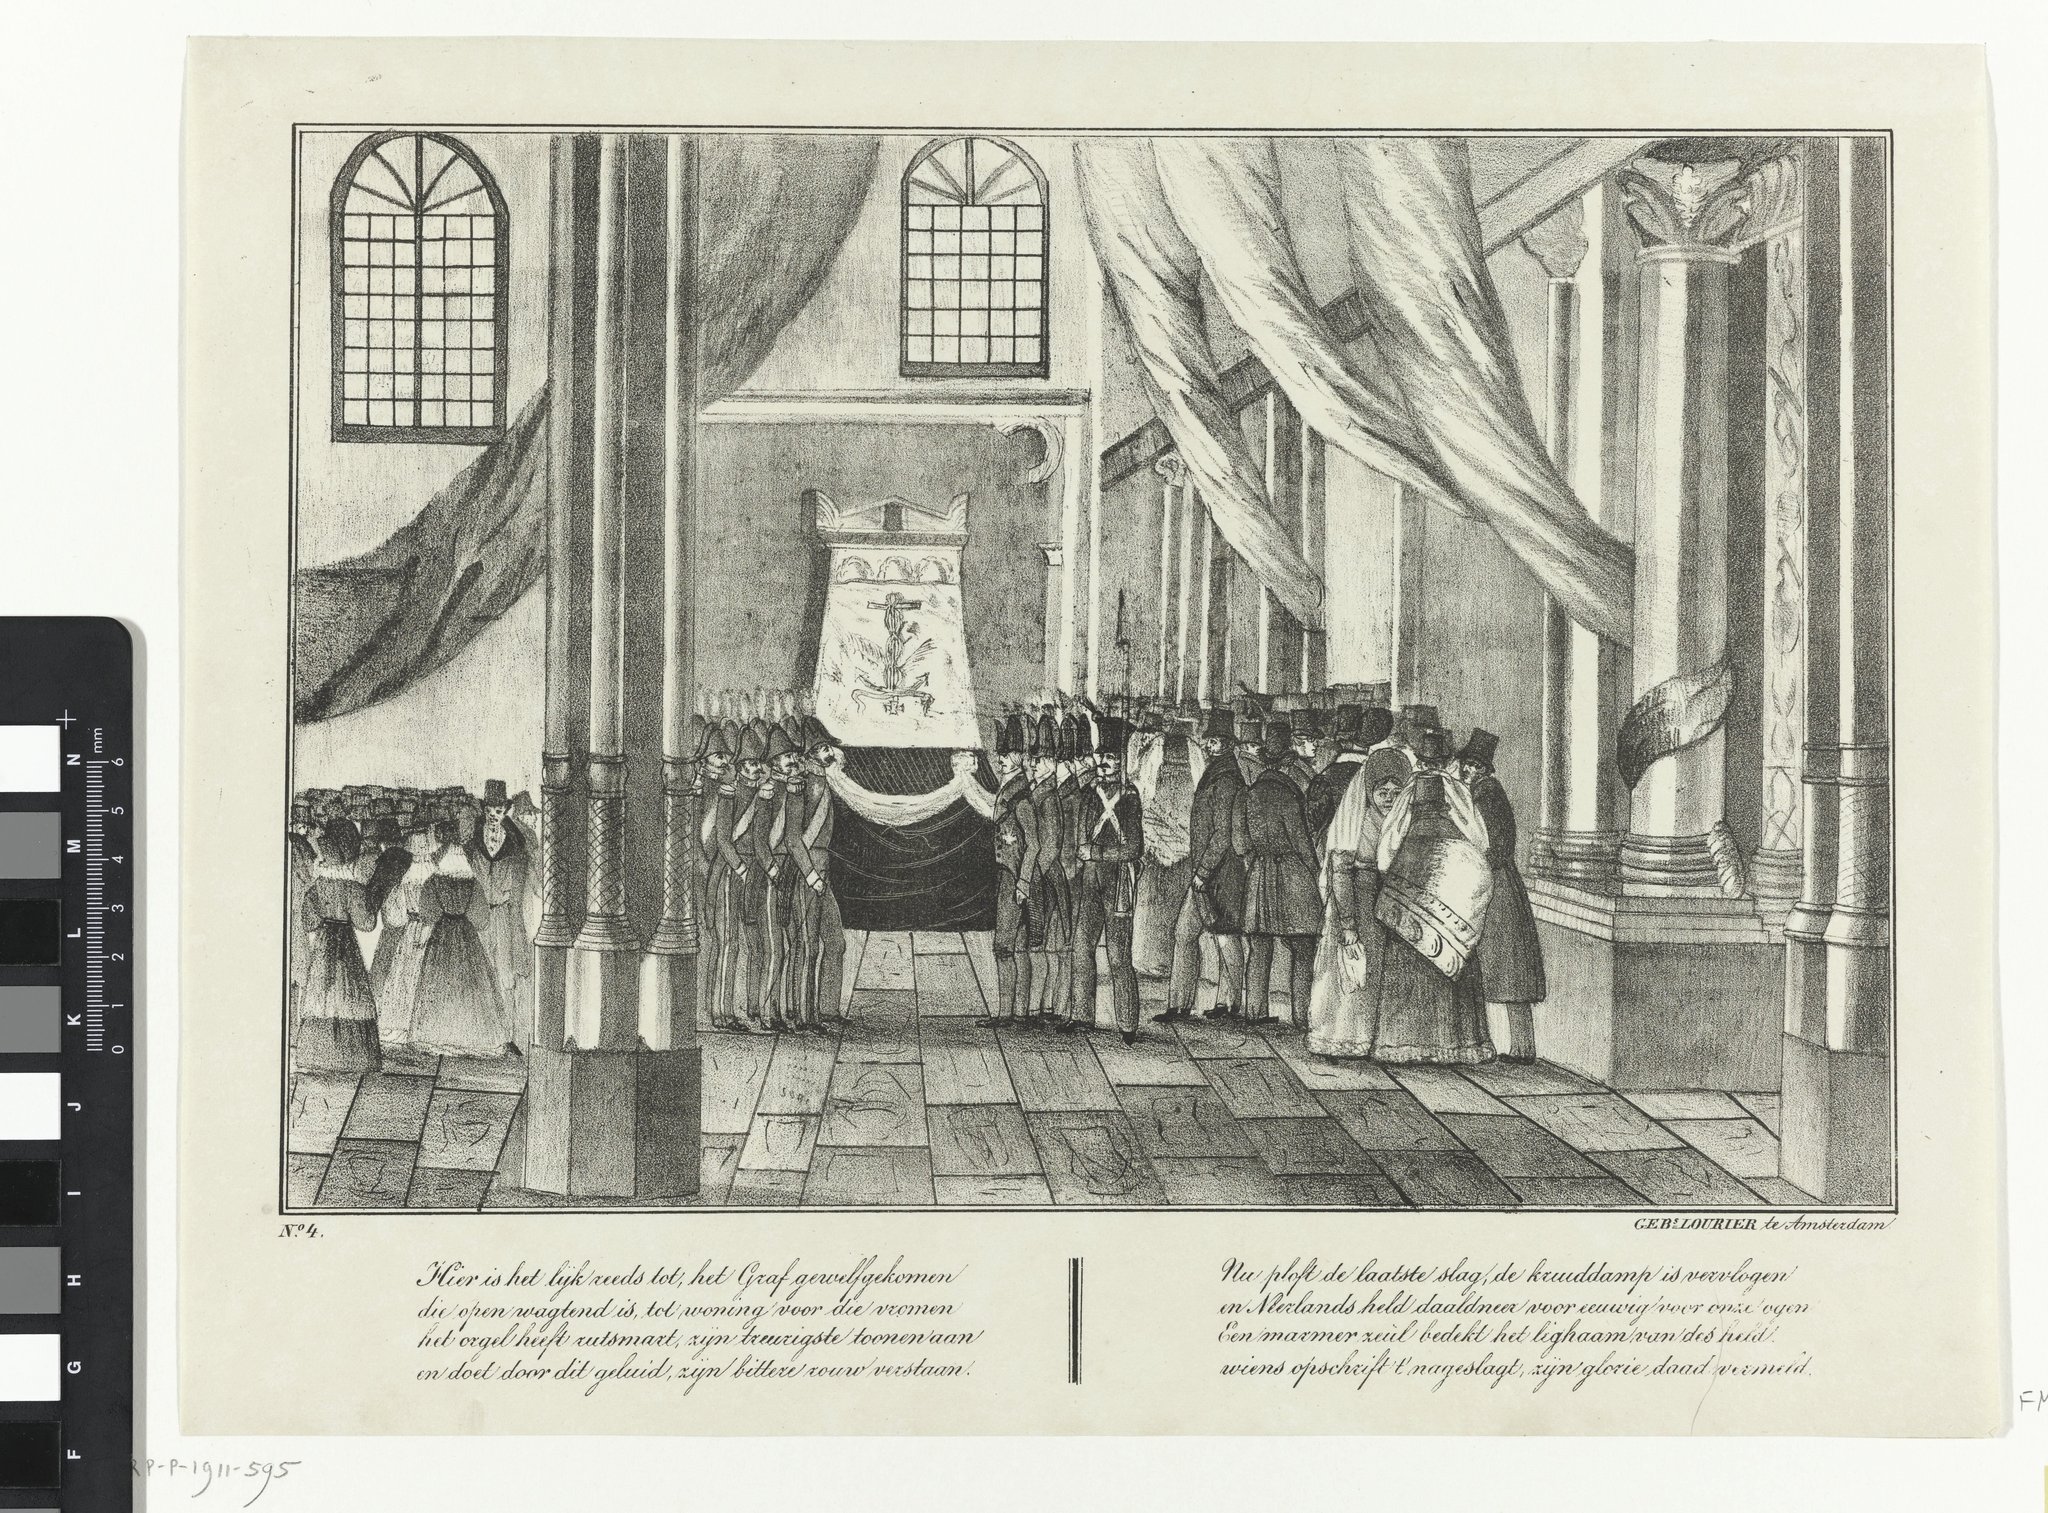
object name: print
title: Begrafenis van Jan van Speyk in de Nieuwe Kerk, 1832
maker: Anonymous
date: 1832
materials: paper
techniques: lithograph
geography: amsterdam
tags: amsterdam, antwerp, jan van speyk, burial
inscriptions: collector's mark: Lugt 2228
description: De begrafenis van de stoffelijke resten van Jan van Speyk in de Nieuwe Kerk te Amsterdam. Militairen en genodigden bij het grafmonument. In het onderschrift twee vierregelige verzen. Vierde plaat in een serie van vier platen van de begrafenis van Jan van Speyk te Amsterdam op 4 met 1832.